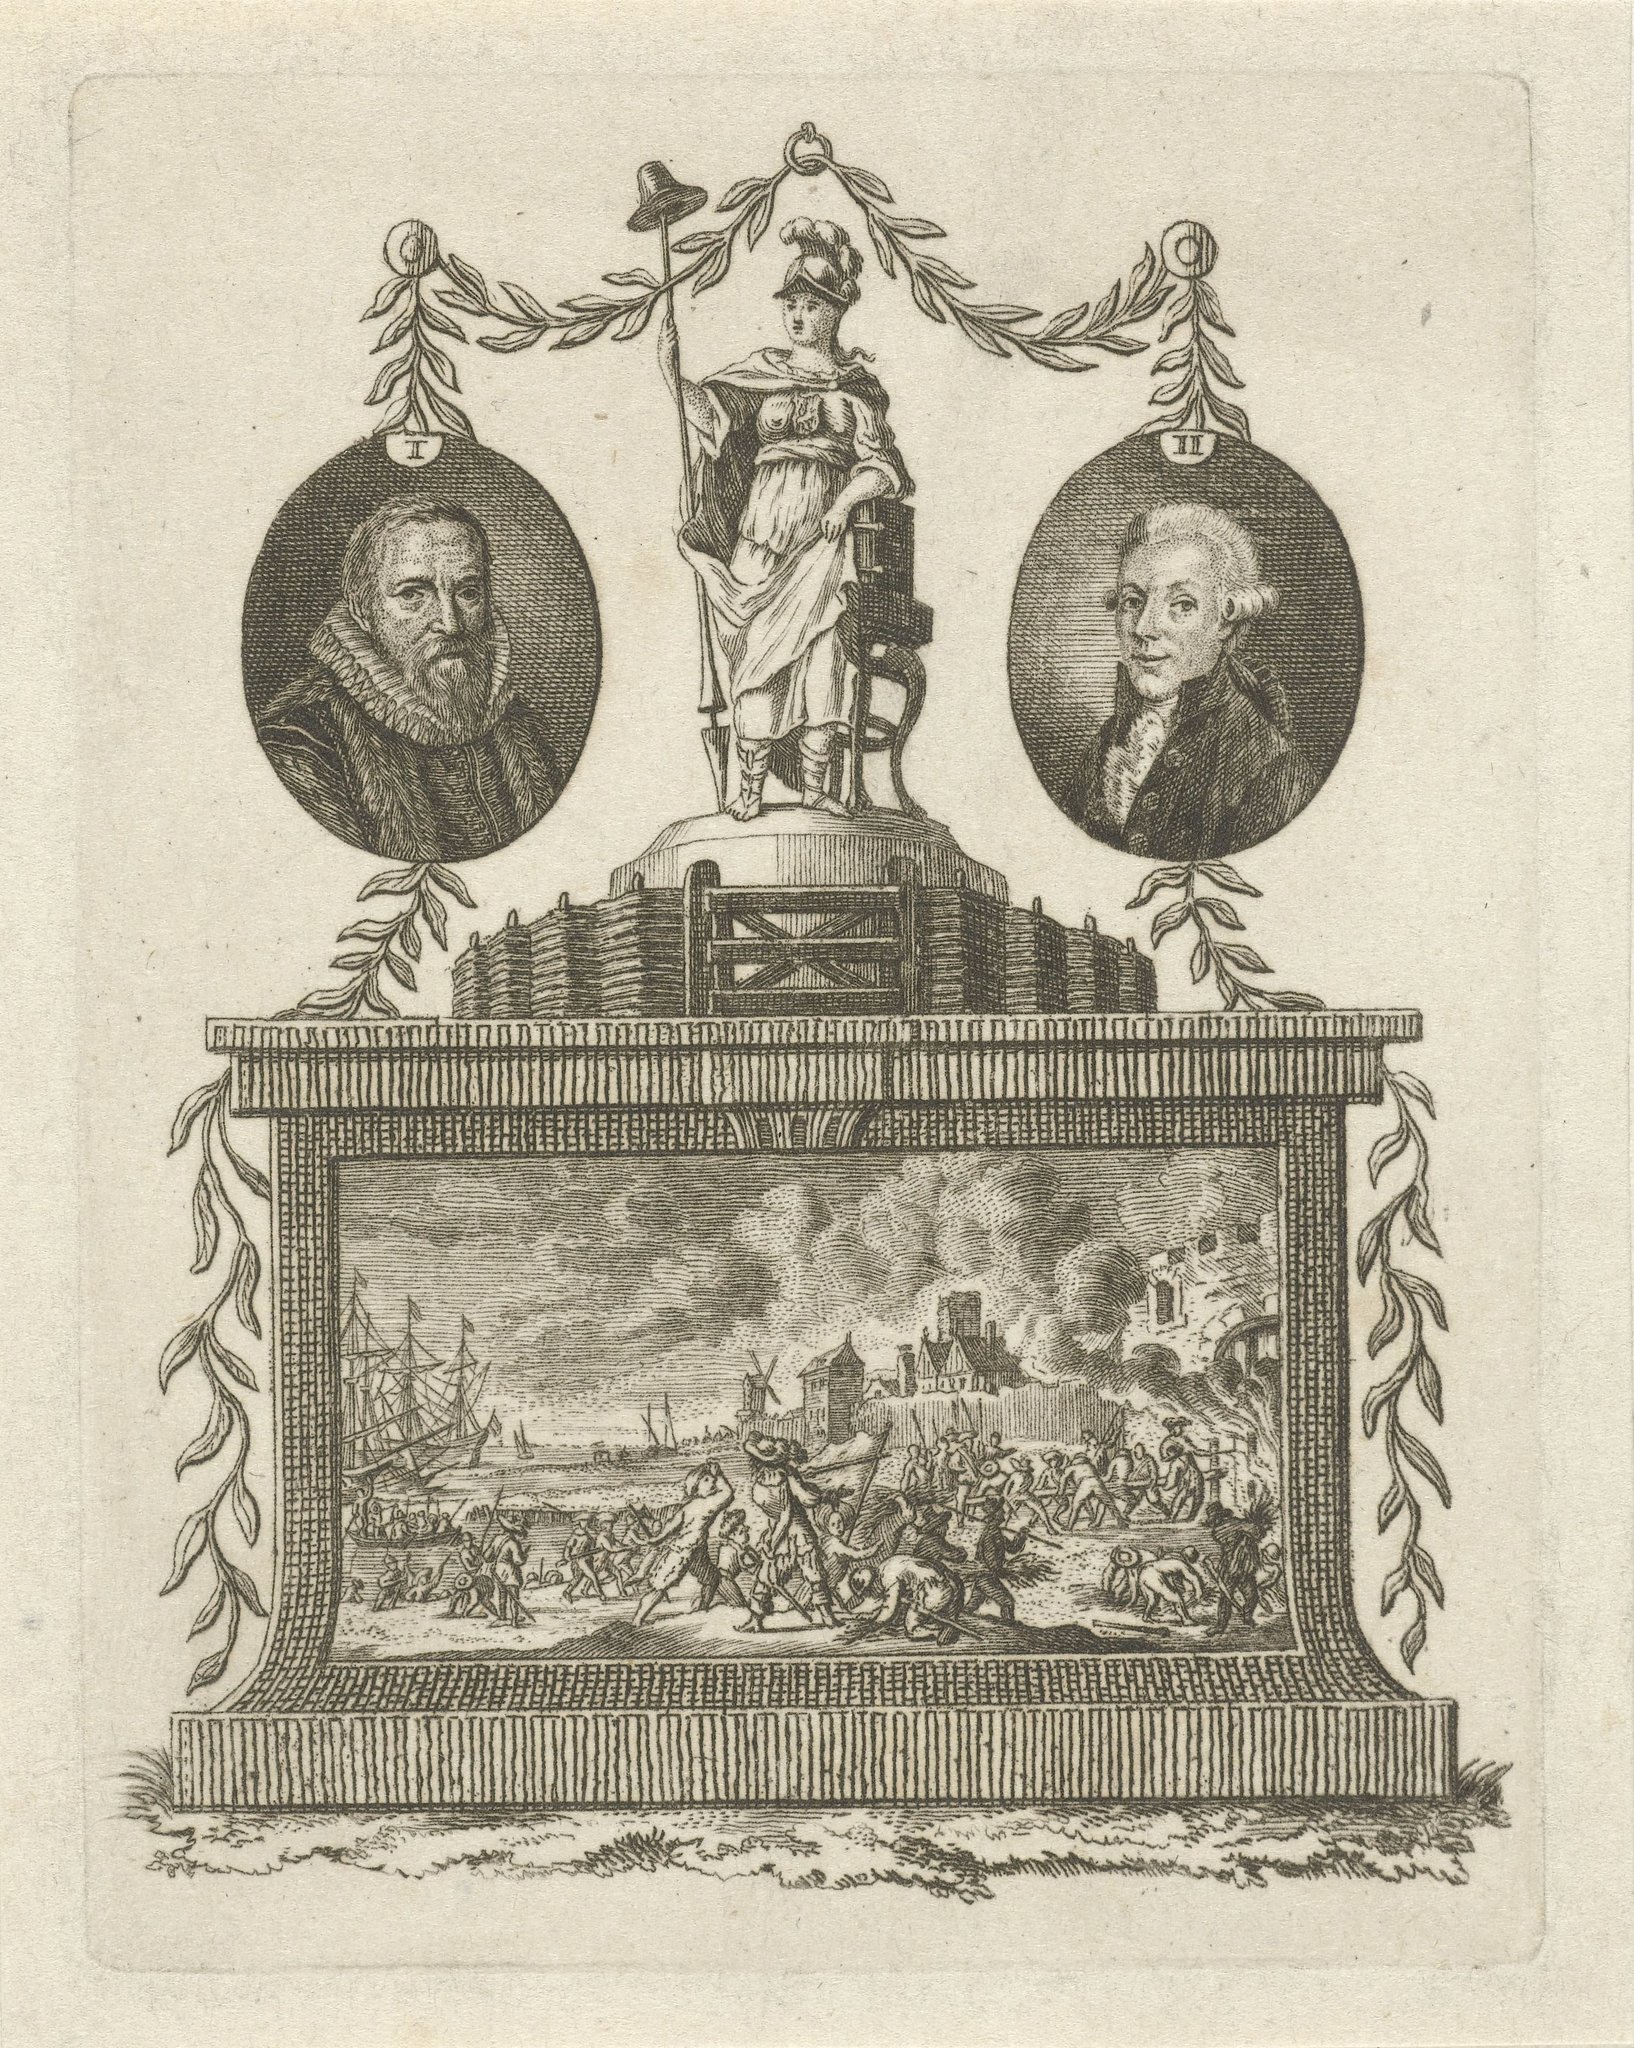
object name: print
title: Inname van den Briel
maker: simon fokke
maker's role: draughtsman, print maker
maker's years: 1712-1784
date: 1722-1784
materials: paper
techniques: etching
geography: amsterdam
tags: freedom, liberty; 'libertà' (ripa), historical events and situations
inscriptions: collector's mark: Lugt 2228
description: De Inname van den Briel afgebeeld met twee historische figuren in ovaal portret. Tussen de portretten staat de personificatie van de Vrijheid met vrijheidshoed op stok.